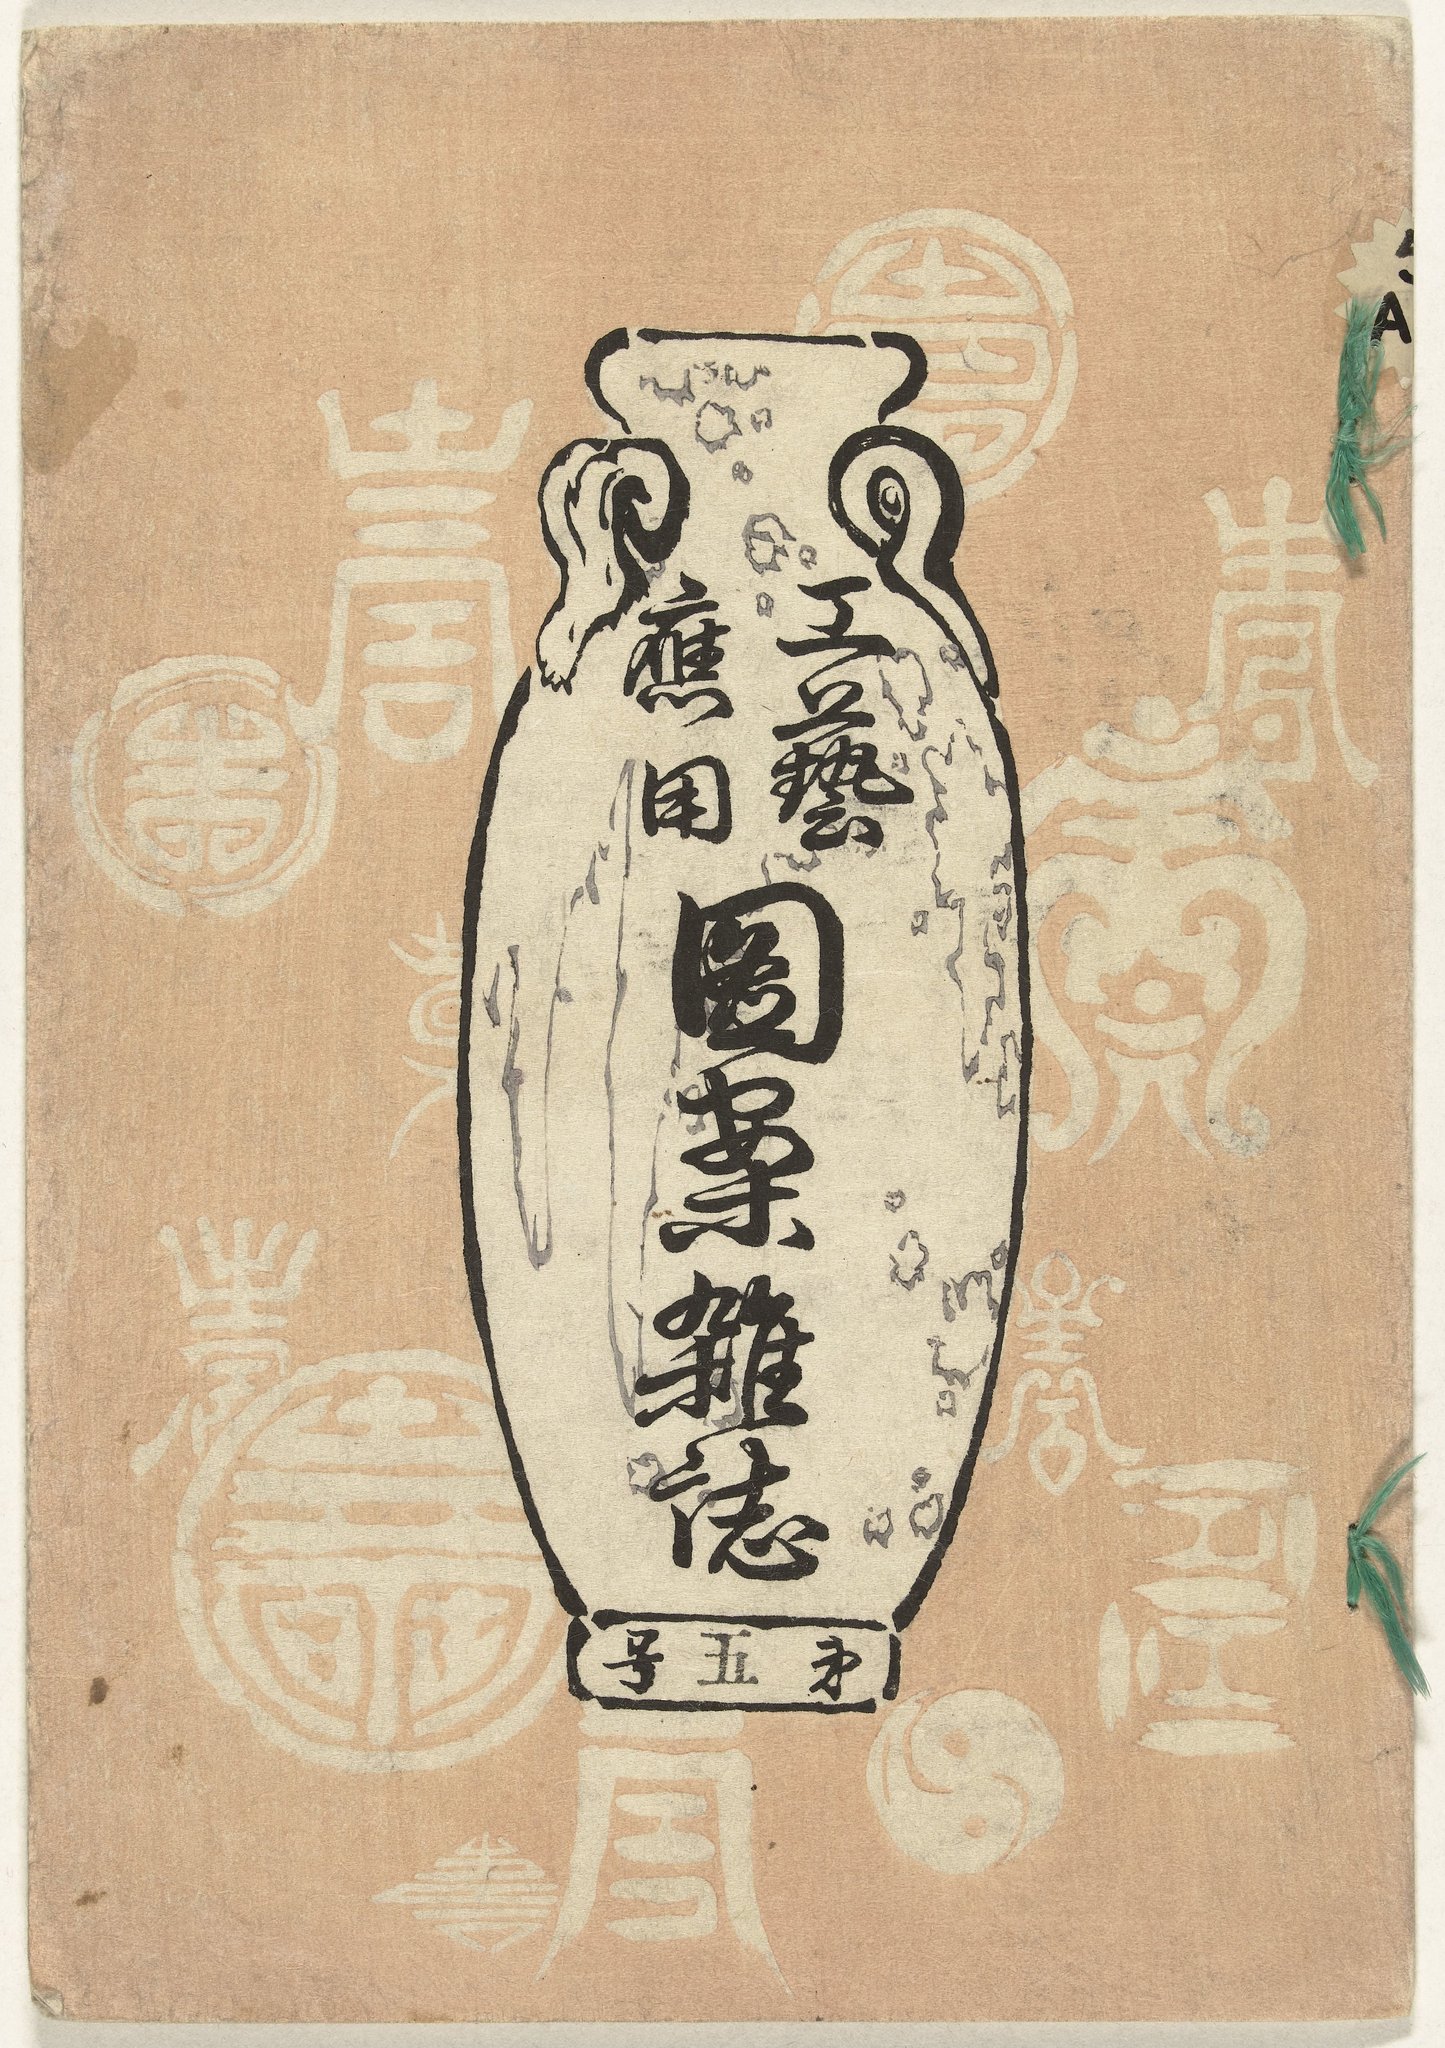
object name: magazine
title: Kogei oyo zuan zasshi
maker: haruna shigeharu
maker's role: publisher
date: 1890-1900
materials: paper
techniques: woodcut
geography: tokyo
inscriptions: collector's mark: Lugt 2228, collector's mark: ‘Rijksschool voor kunstnijverheid’ Lugt 3937